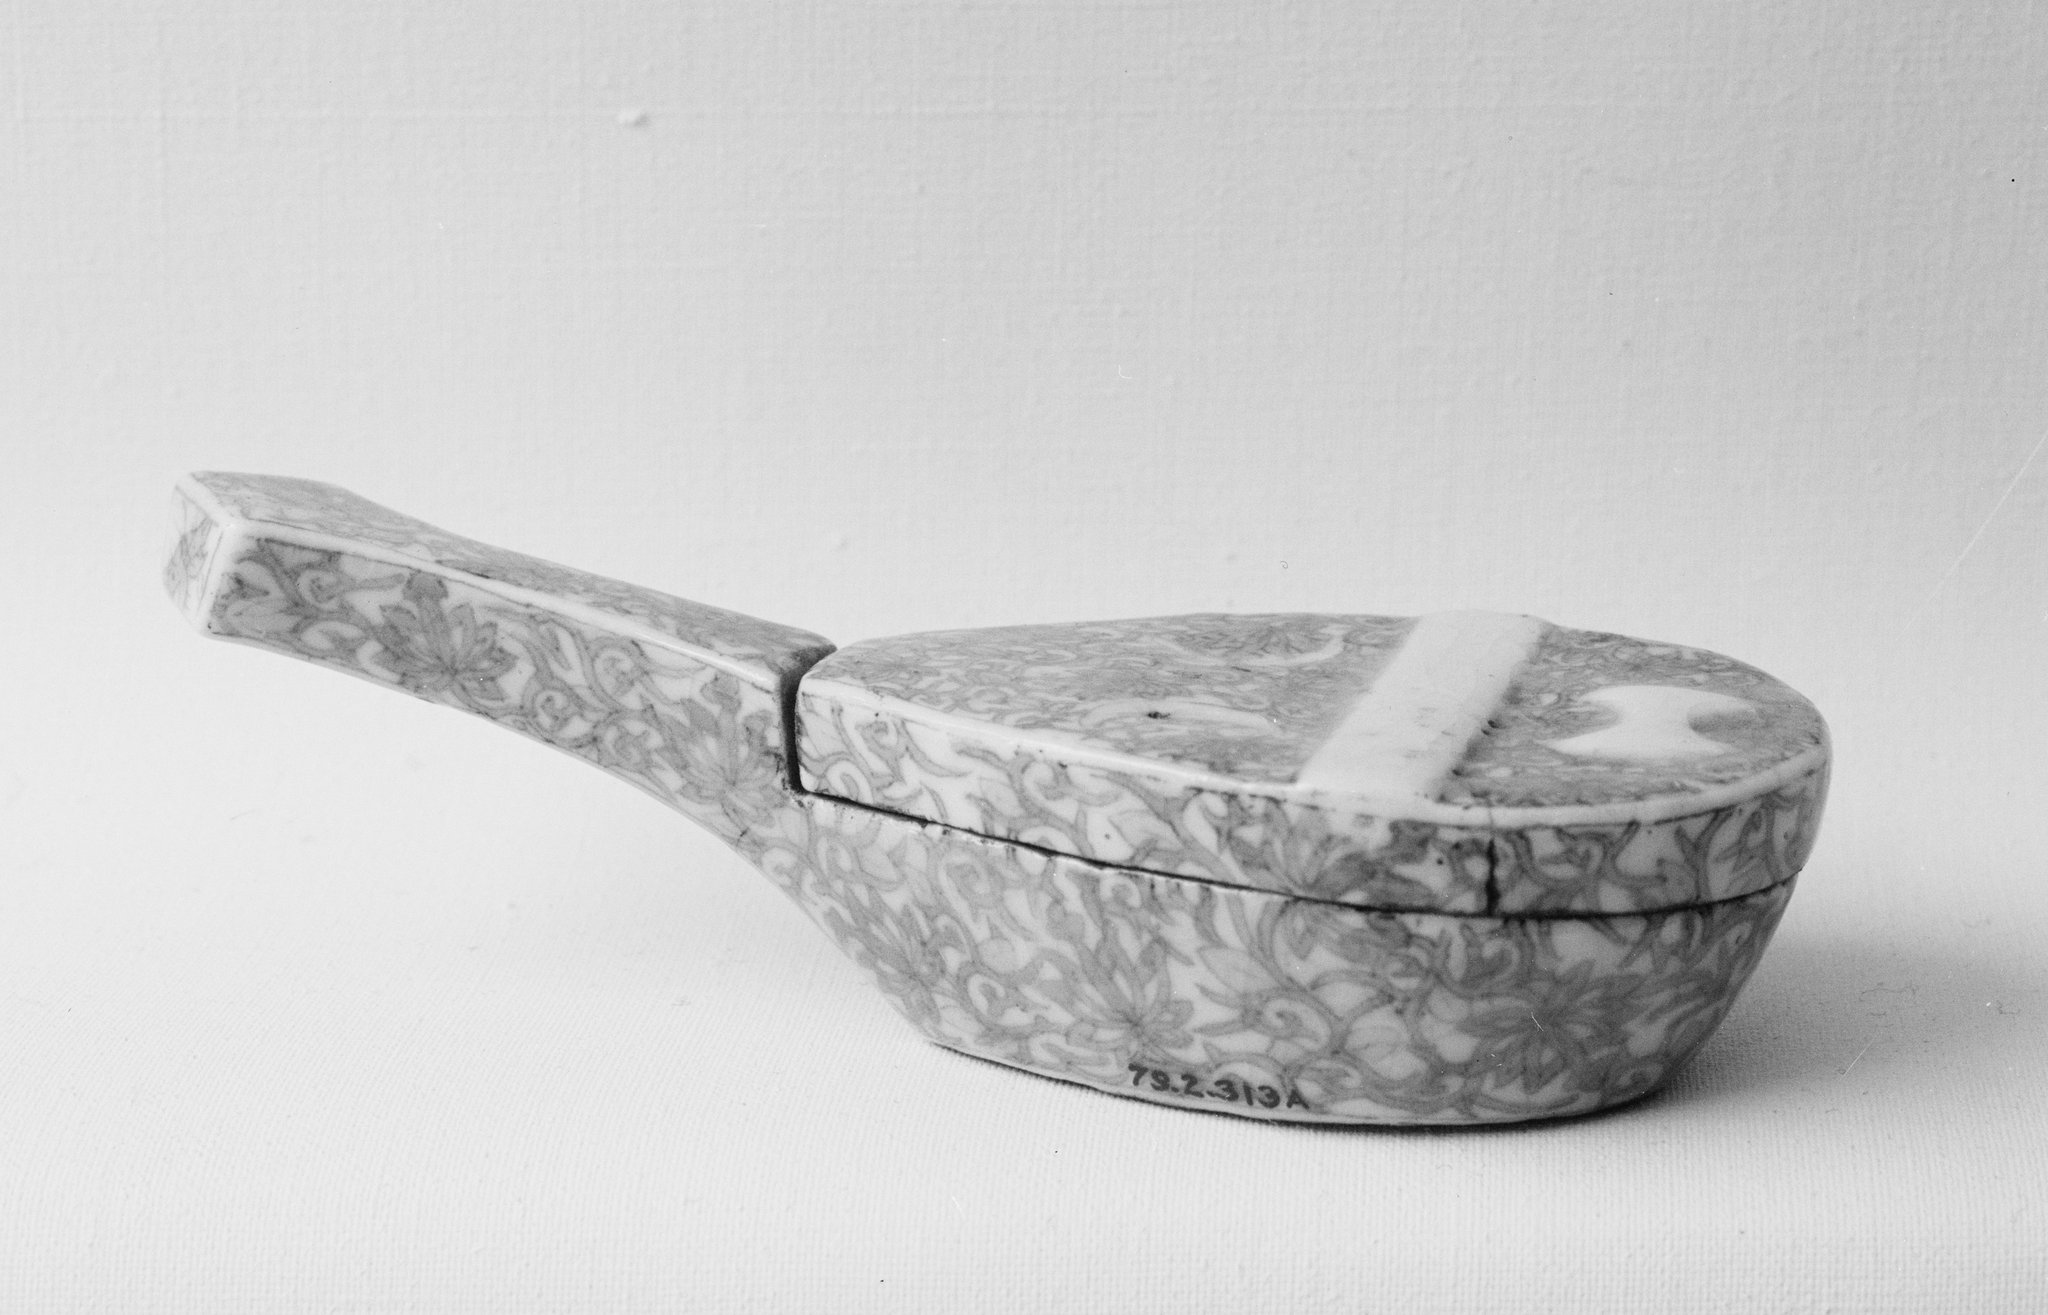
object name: incense box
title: Covered Incense Box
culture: japanese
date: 1801-1900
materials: glaze, porcelain